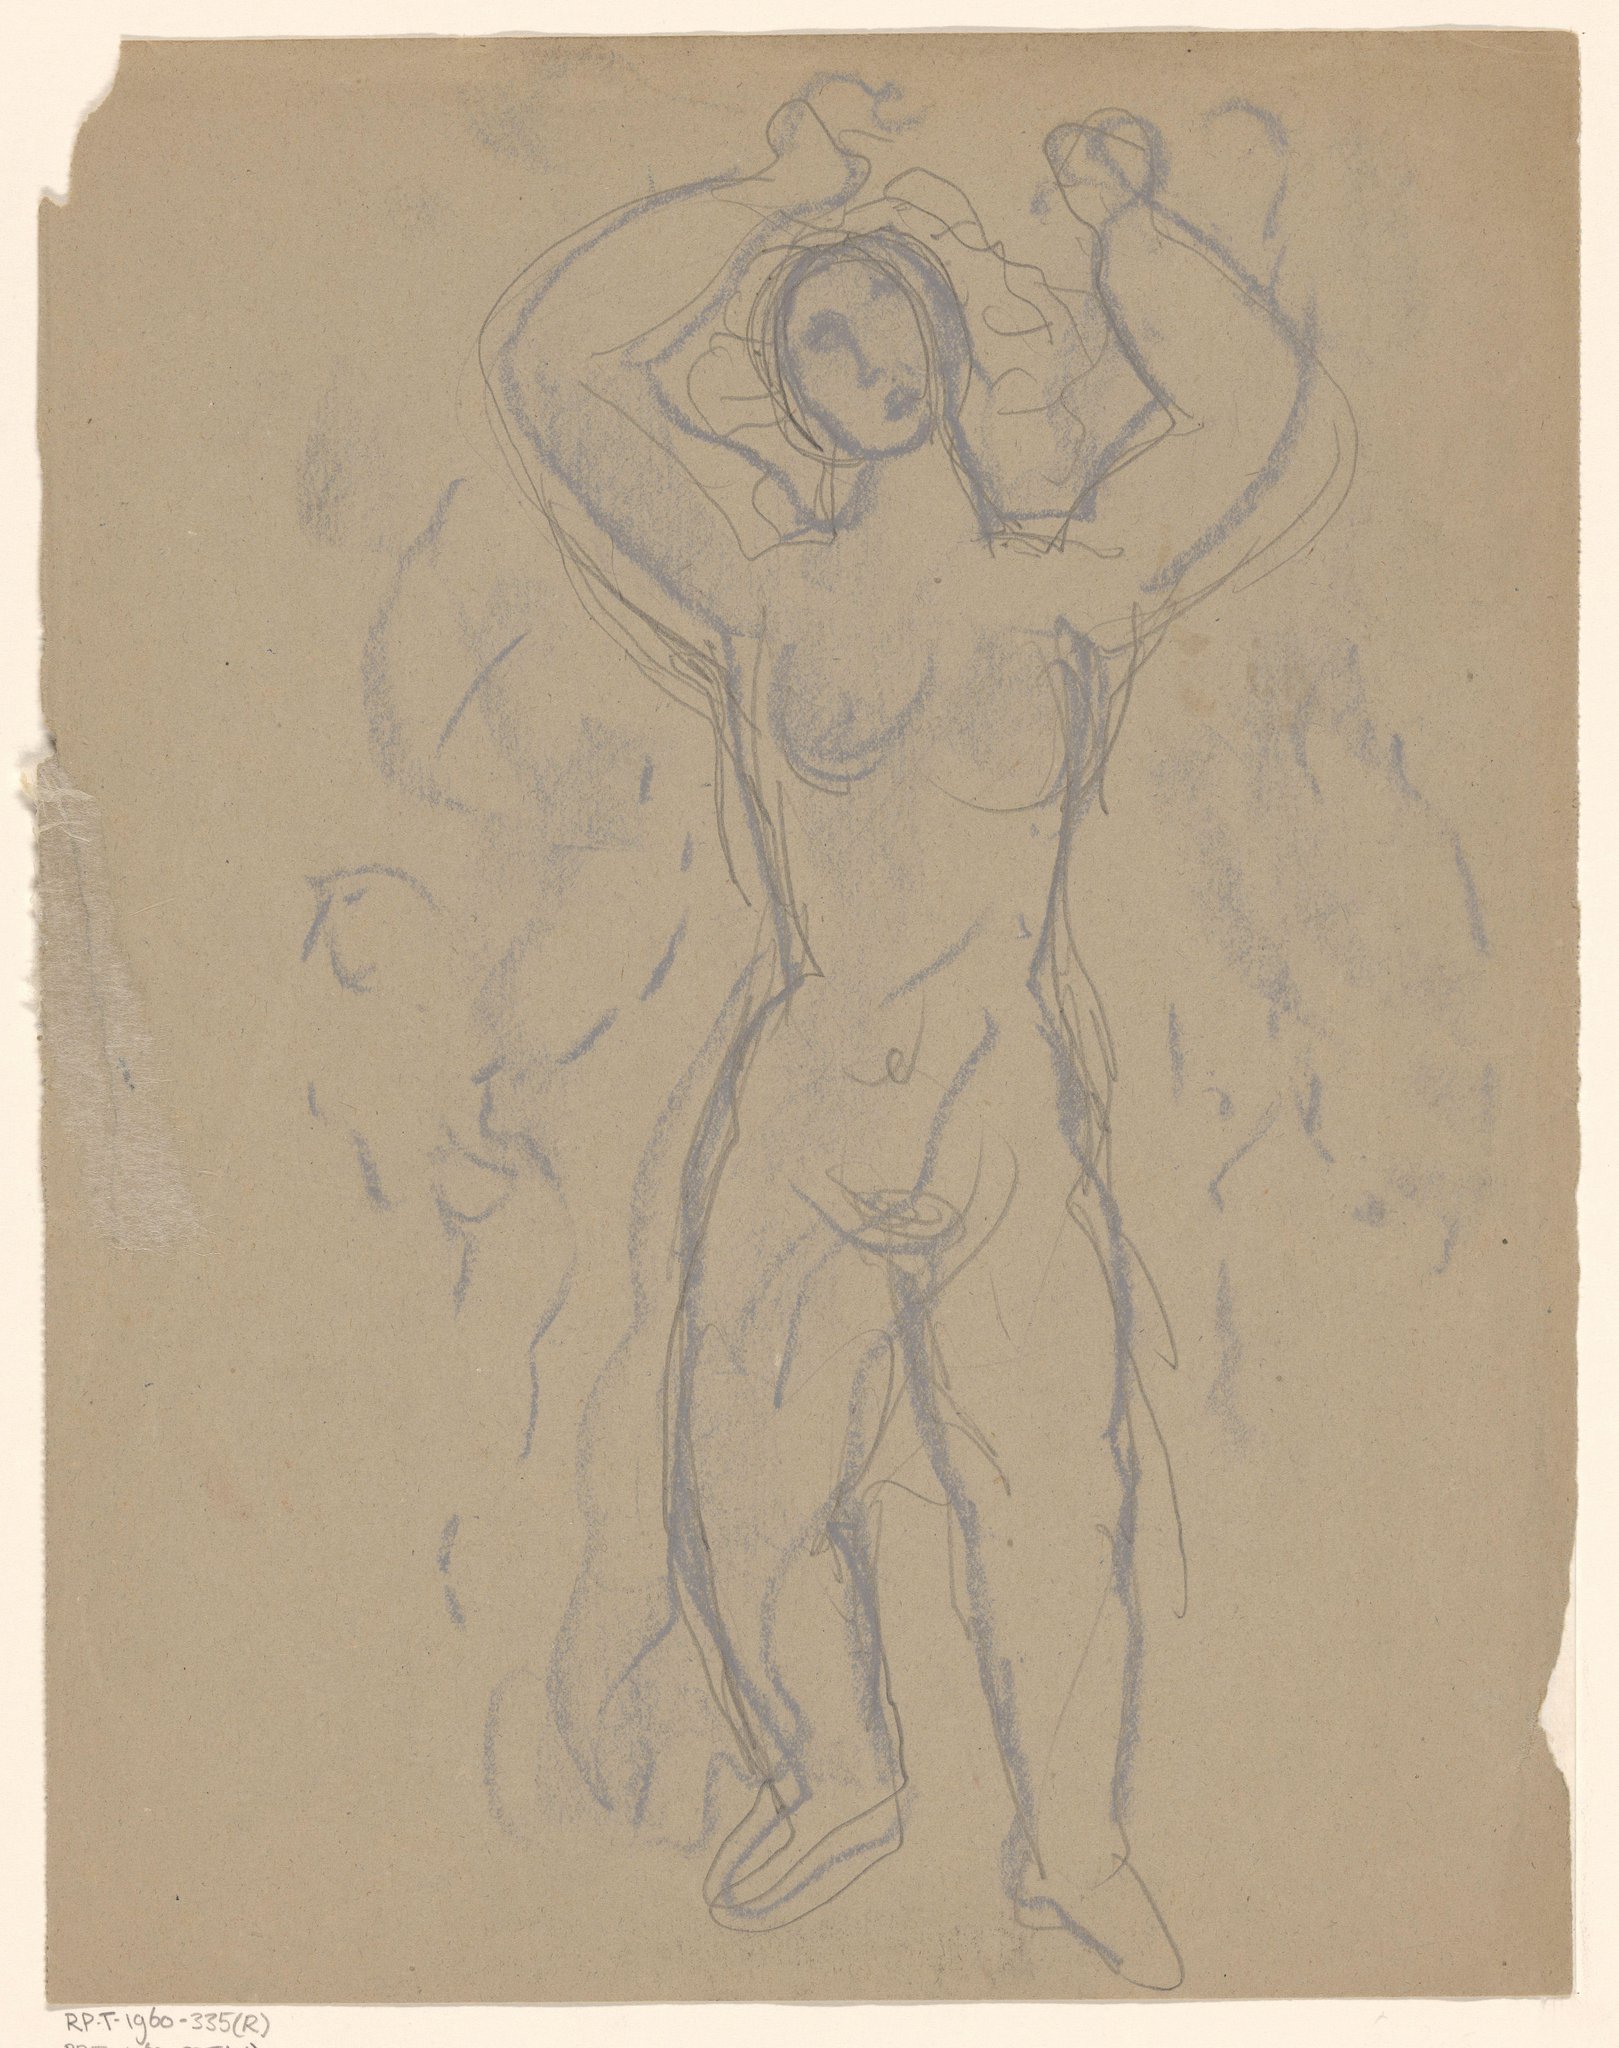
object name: drawing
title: Naakte vrouw met de handen boven het hoofd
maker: leo gestel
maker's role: draughtsman, print maker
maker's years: 1881-1941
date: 1891-1941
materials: chalk, paper, pencil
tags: female sex; woman (+ nude human being)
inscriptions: collector's mark: Lugt 2228